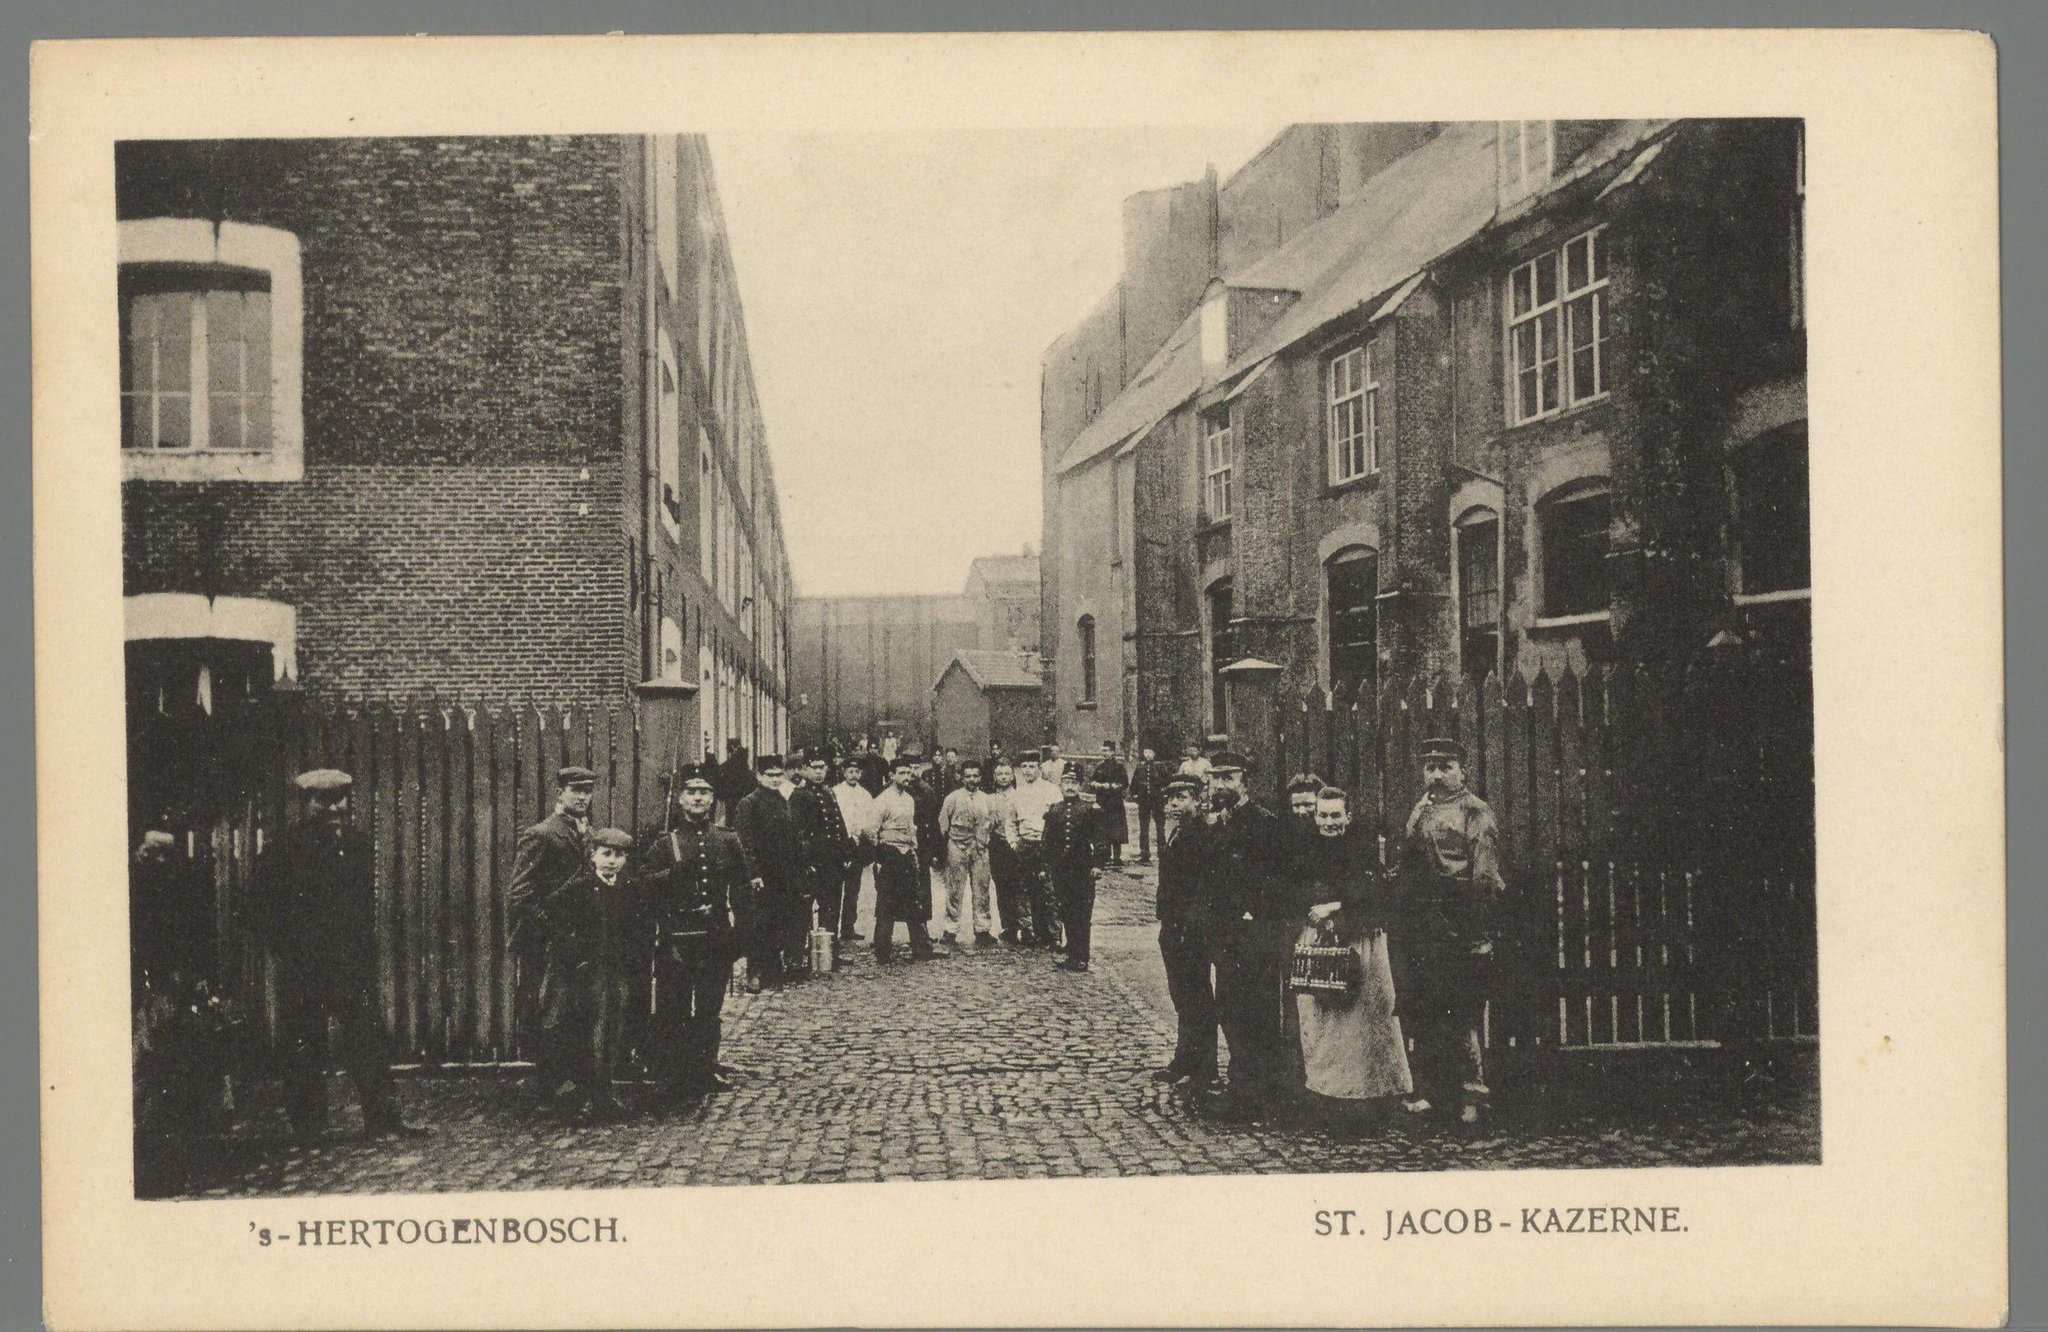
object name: ansichtkaart, prentbriefkaart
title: 's-Hertogenbosch. St. Jacob-Kazerne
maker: Anonymous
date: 1905-1930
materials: cardboard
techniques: photograph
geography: den bosch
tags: soldiers and civilians, barracks, den bosch